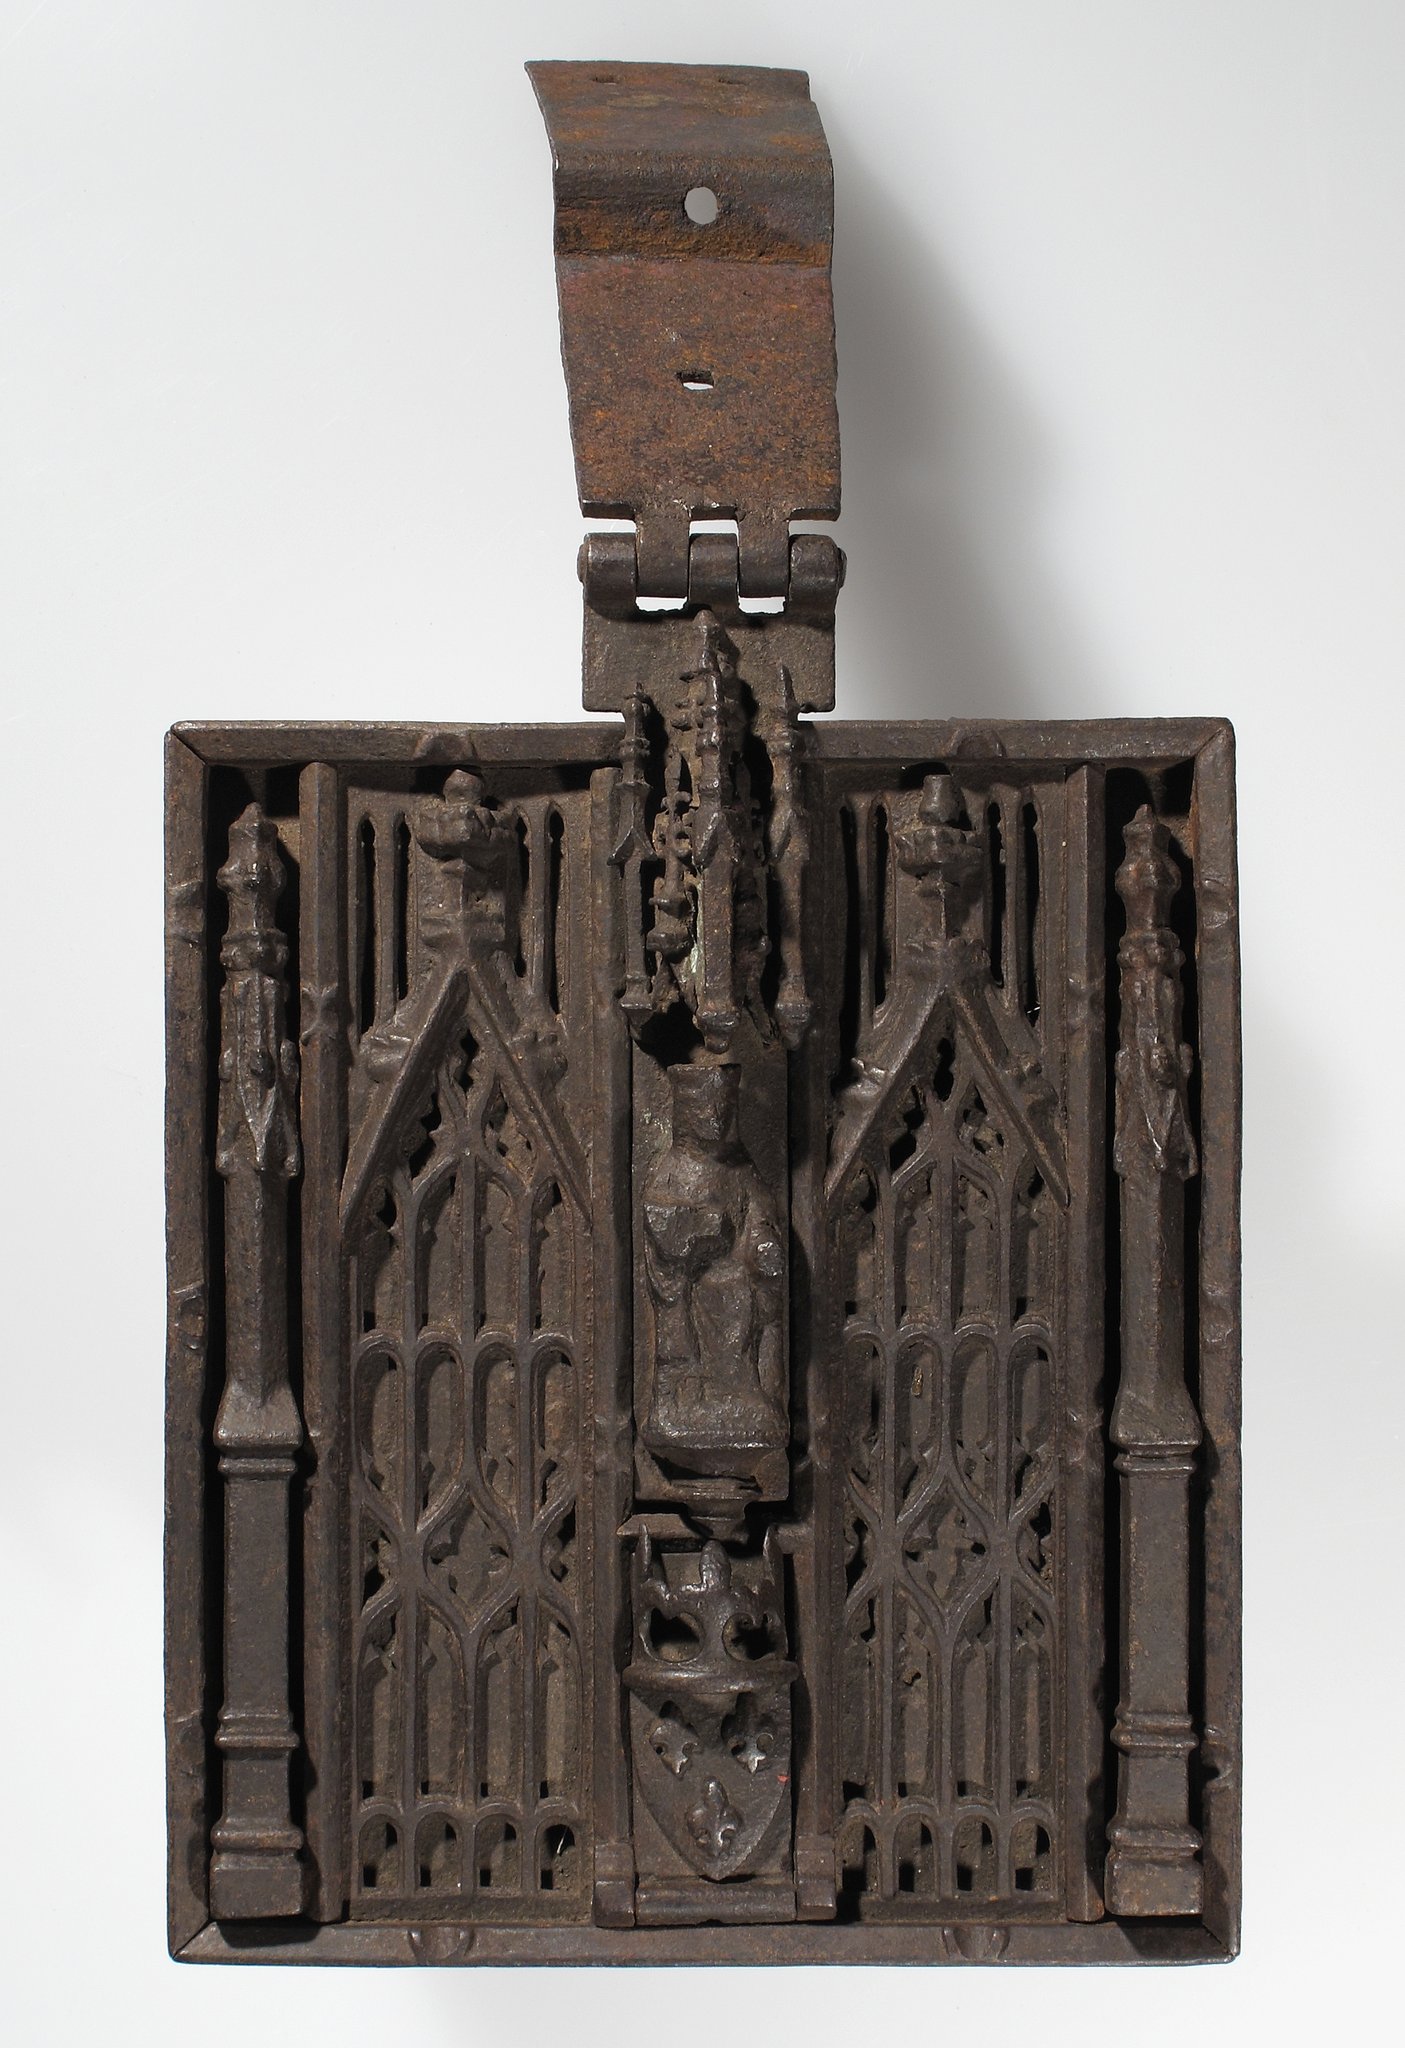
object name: lock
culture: french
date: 1401-1600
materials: iron